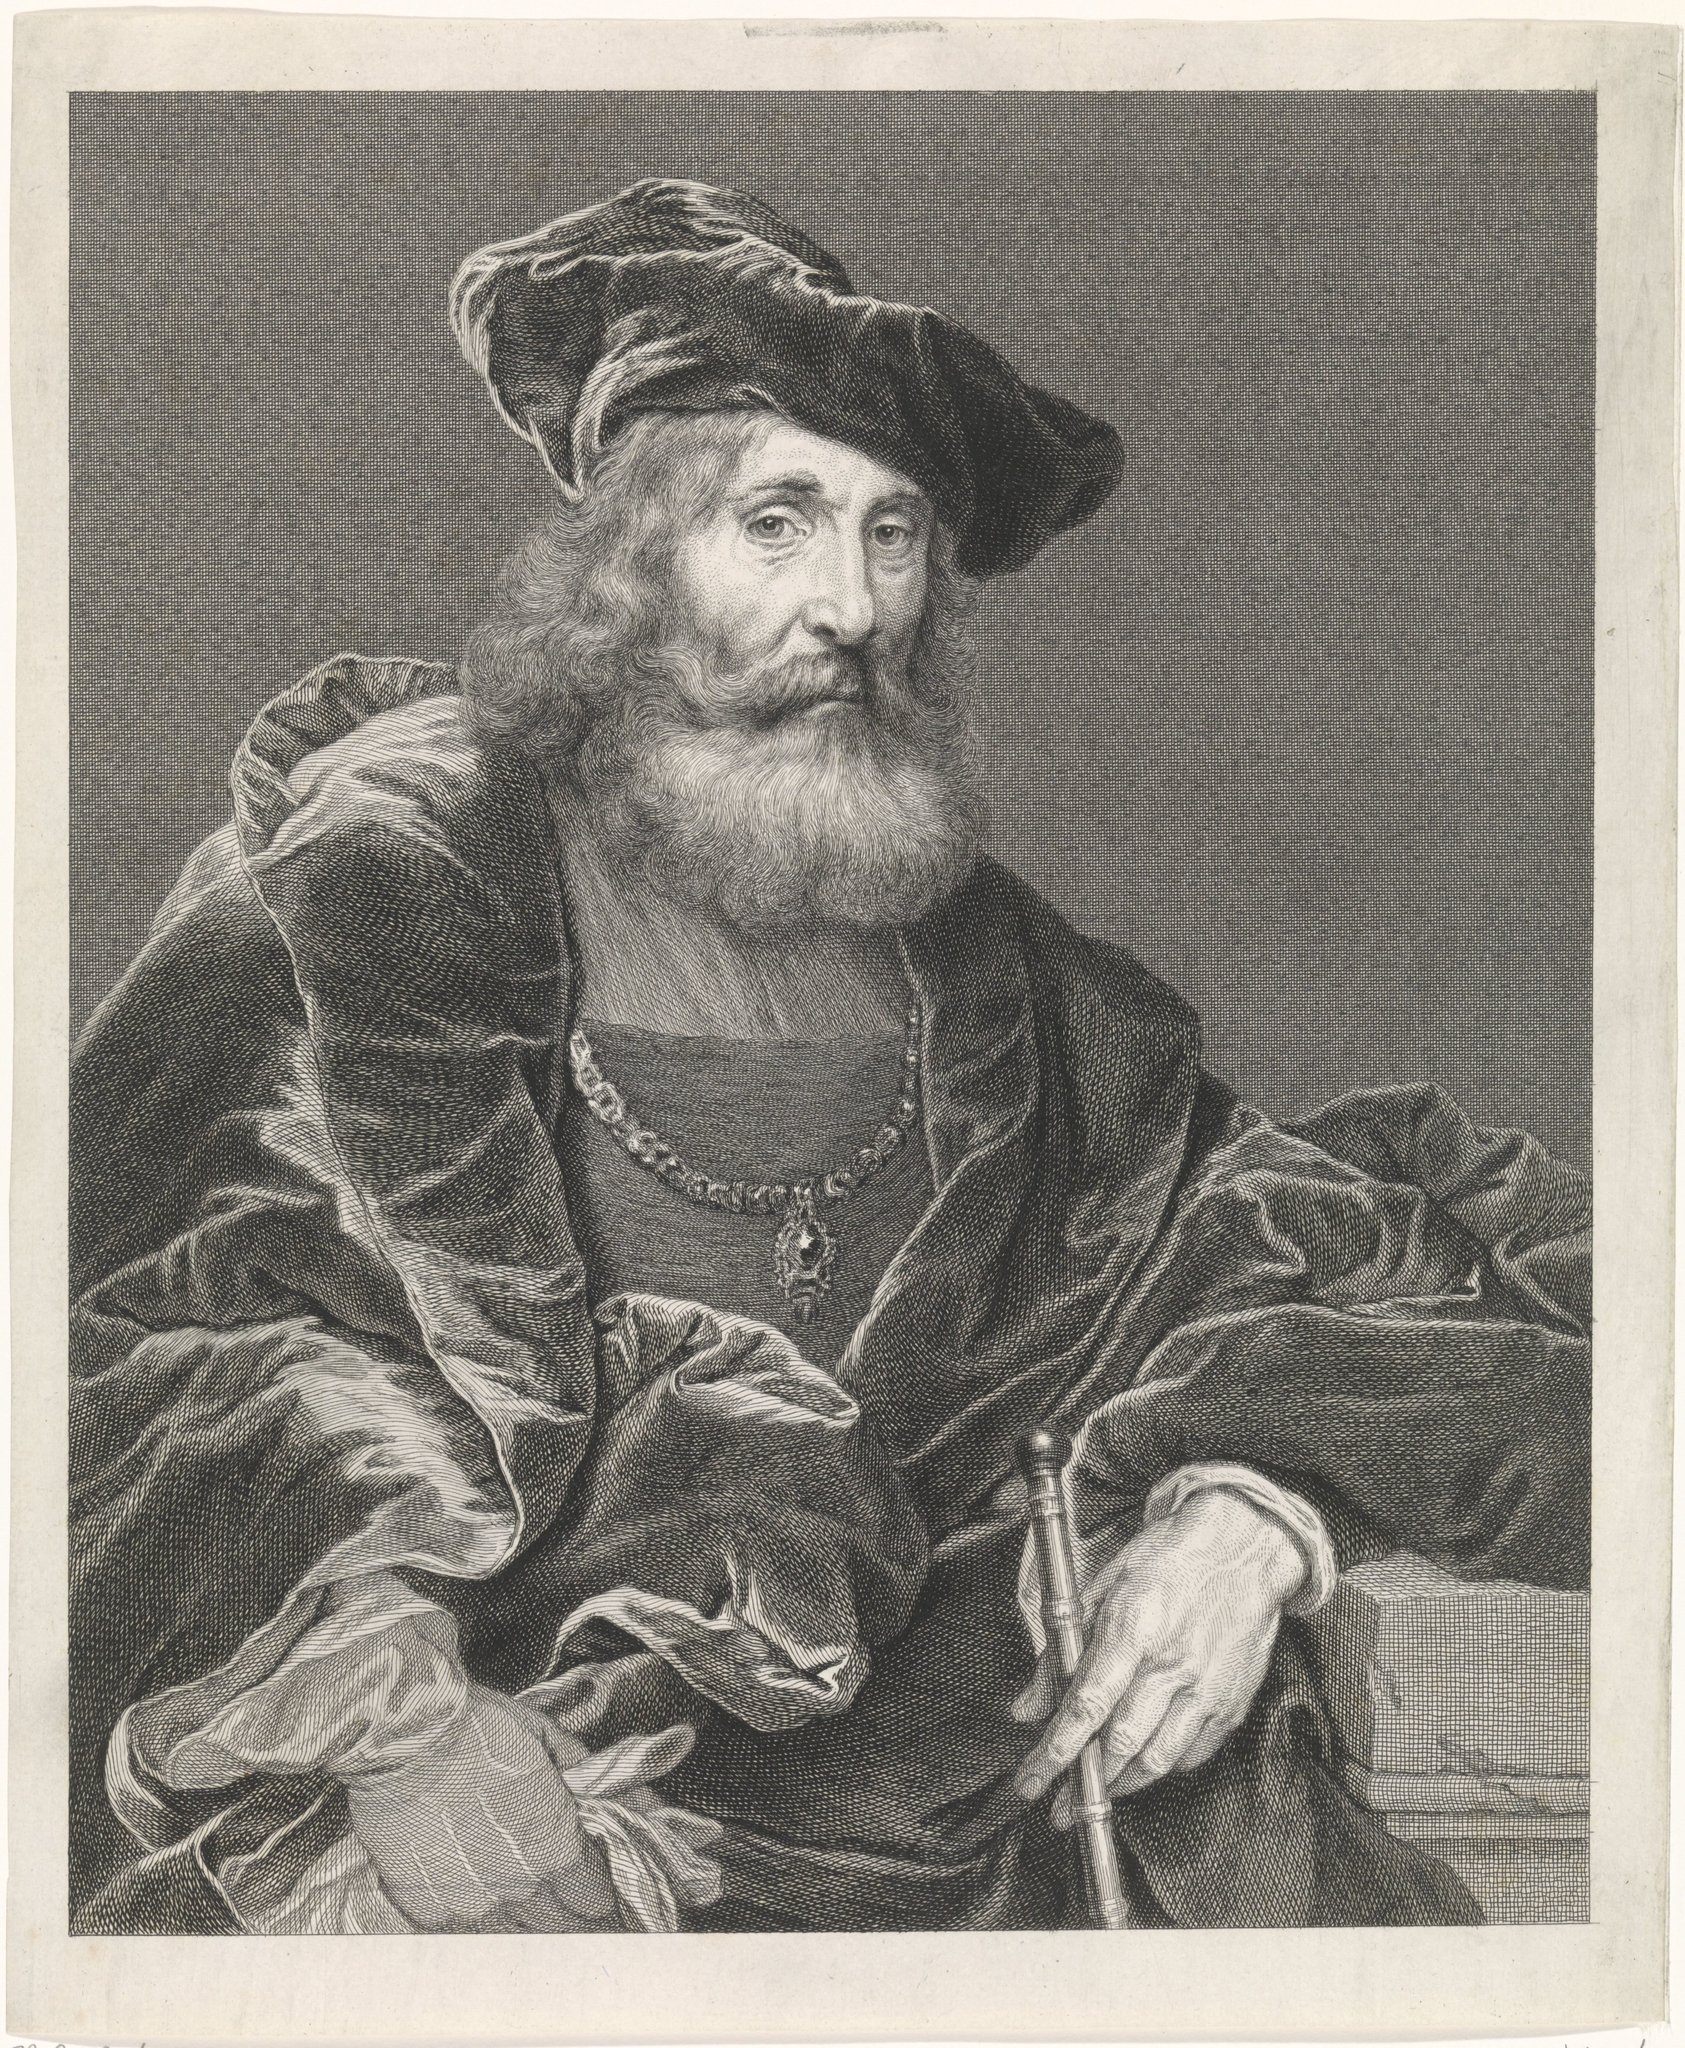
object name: print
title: Portret van een bebaarde man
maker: pieter tanjé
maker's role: draughtsman, print maker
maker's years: 1706-1761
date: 1716-1761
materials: paper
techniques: engraving, etching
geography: amsterdam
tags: head-gear: beret (+ men's clothes), beard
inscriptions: collector's mark: Lugt 240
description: Portret van een bebaarde man met een baret op het hoofd en een staf in de hand. Om zijn hals een ketting met een hanger.